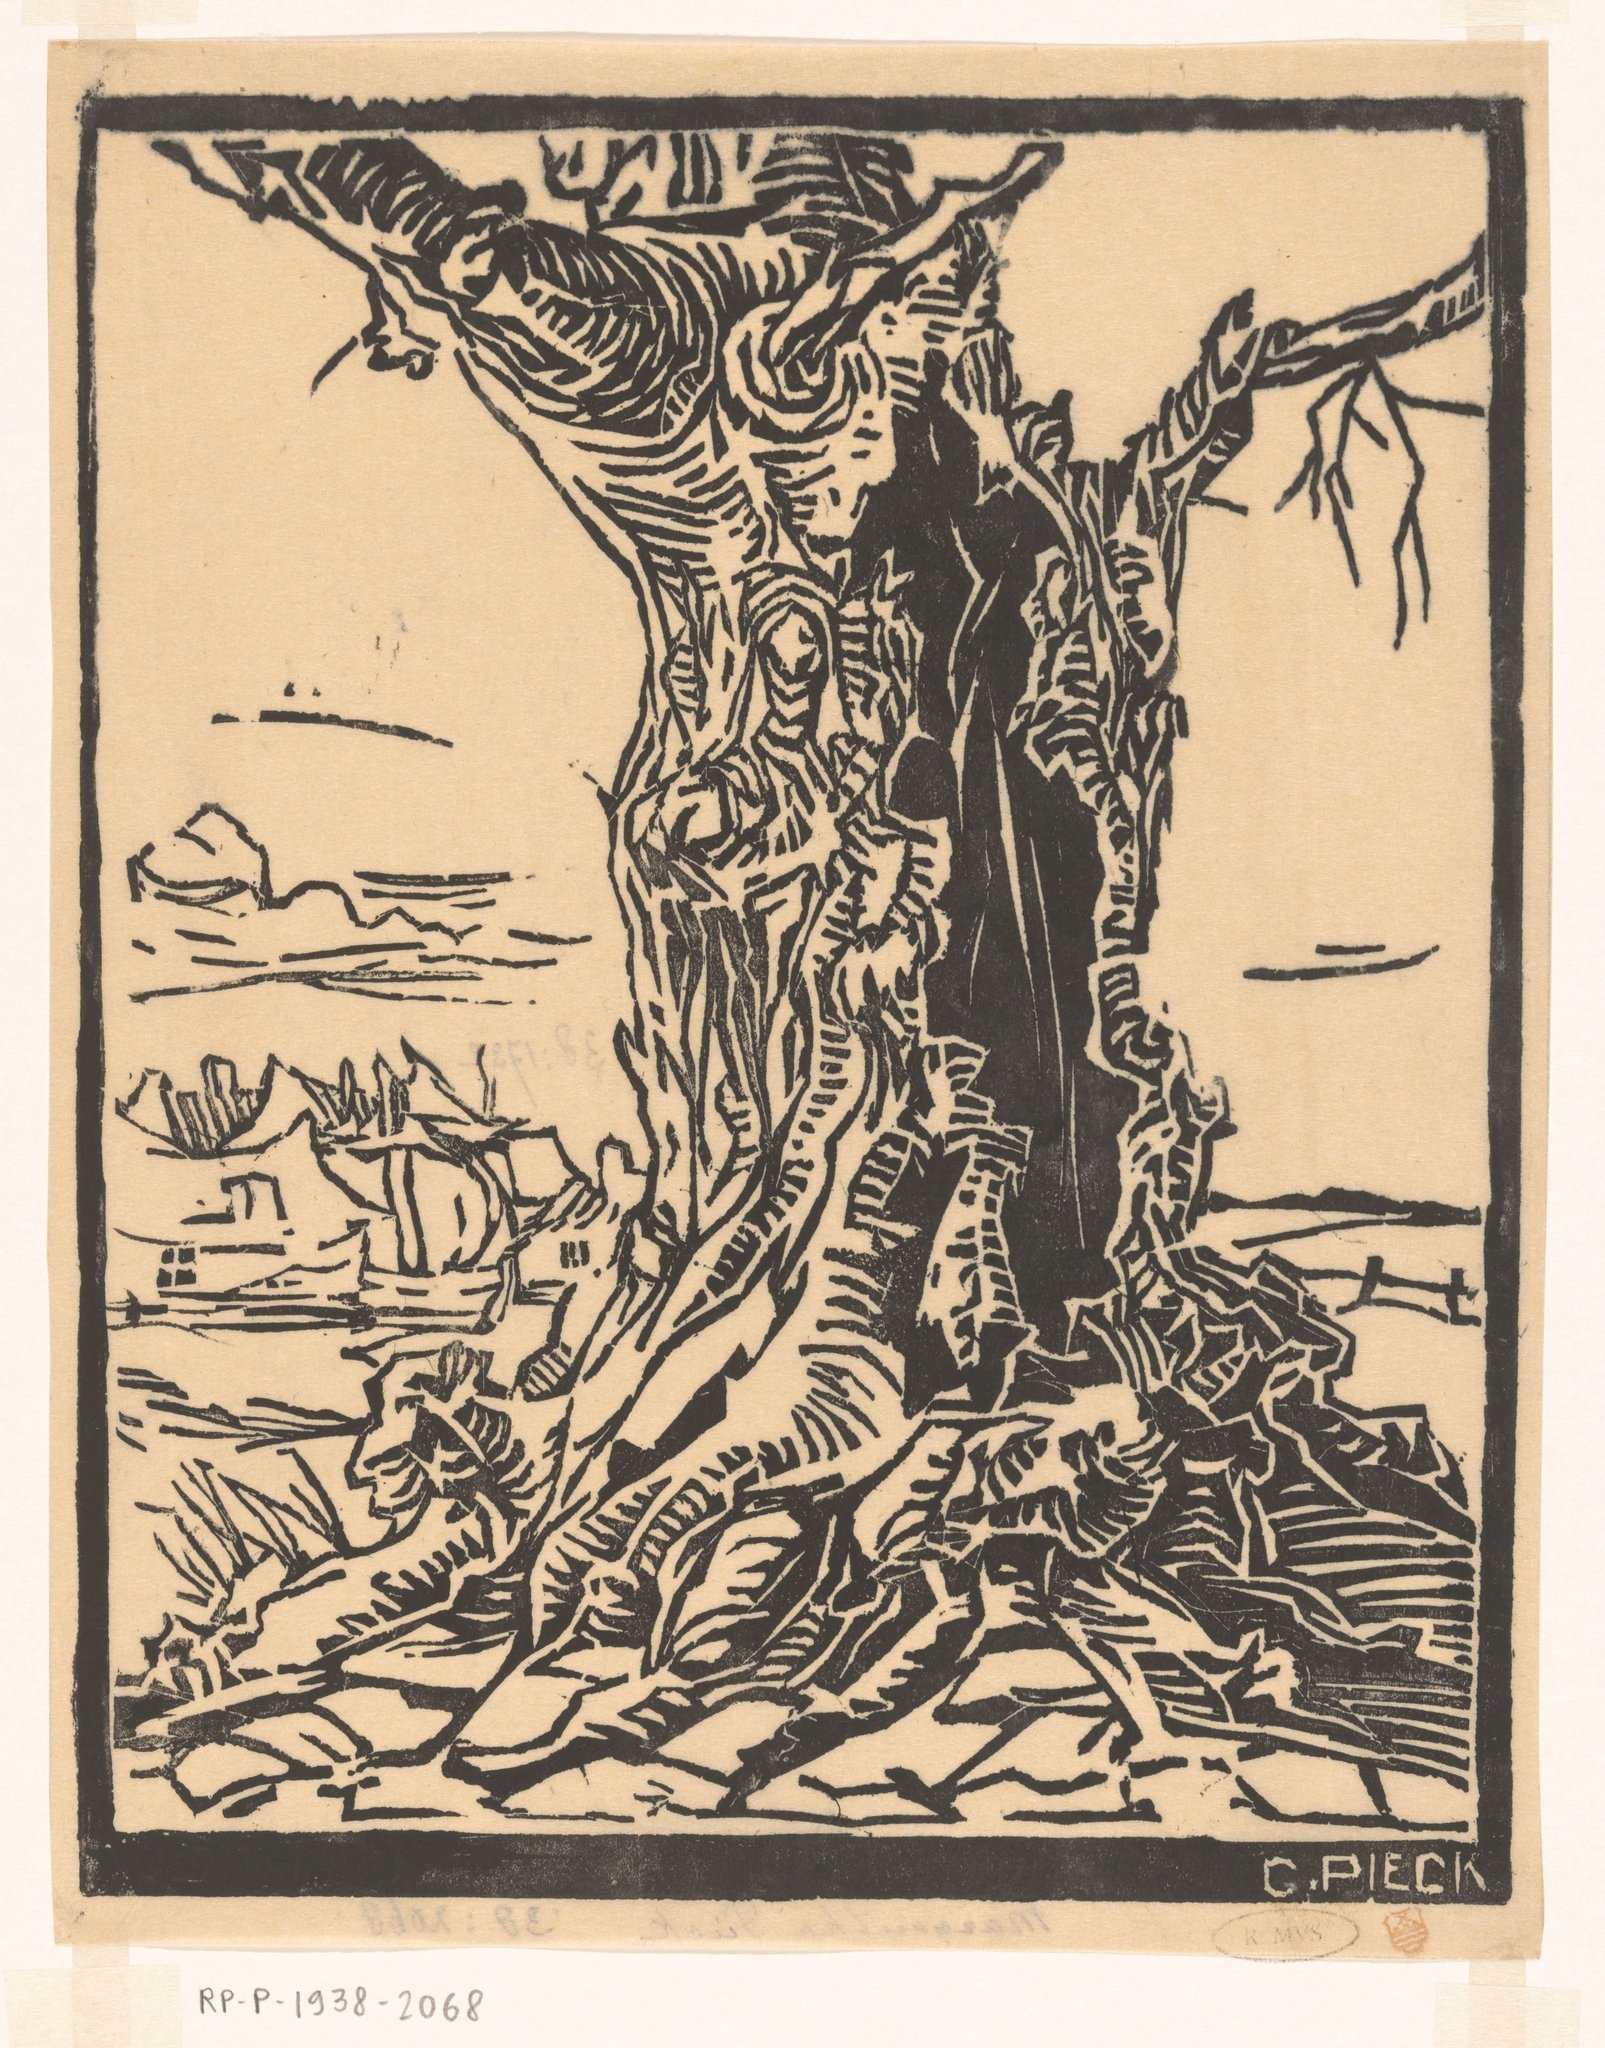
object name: print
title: Linde in Lage Vuursche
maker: gretha pieck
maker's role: print maker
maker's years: 1898-1920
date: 1908-1920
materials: paper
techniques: woodcut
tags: trees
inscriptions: collector's mark: Lugt 2228, collector's mark: Lugt 2760